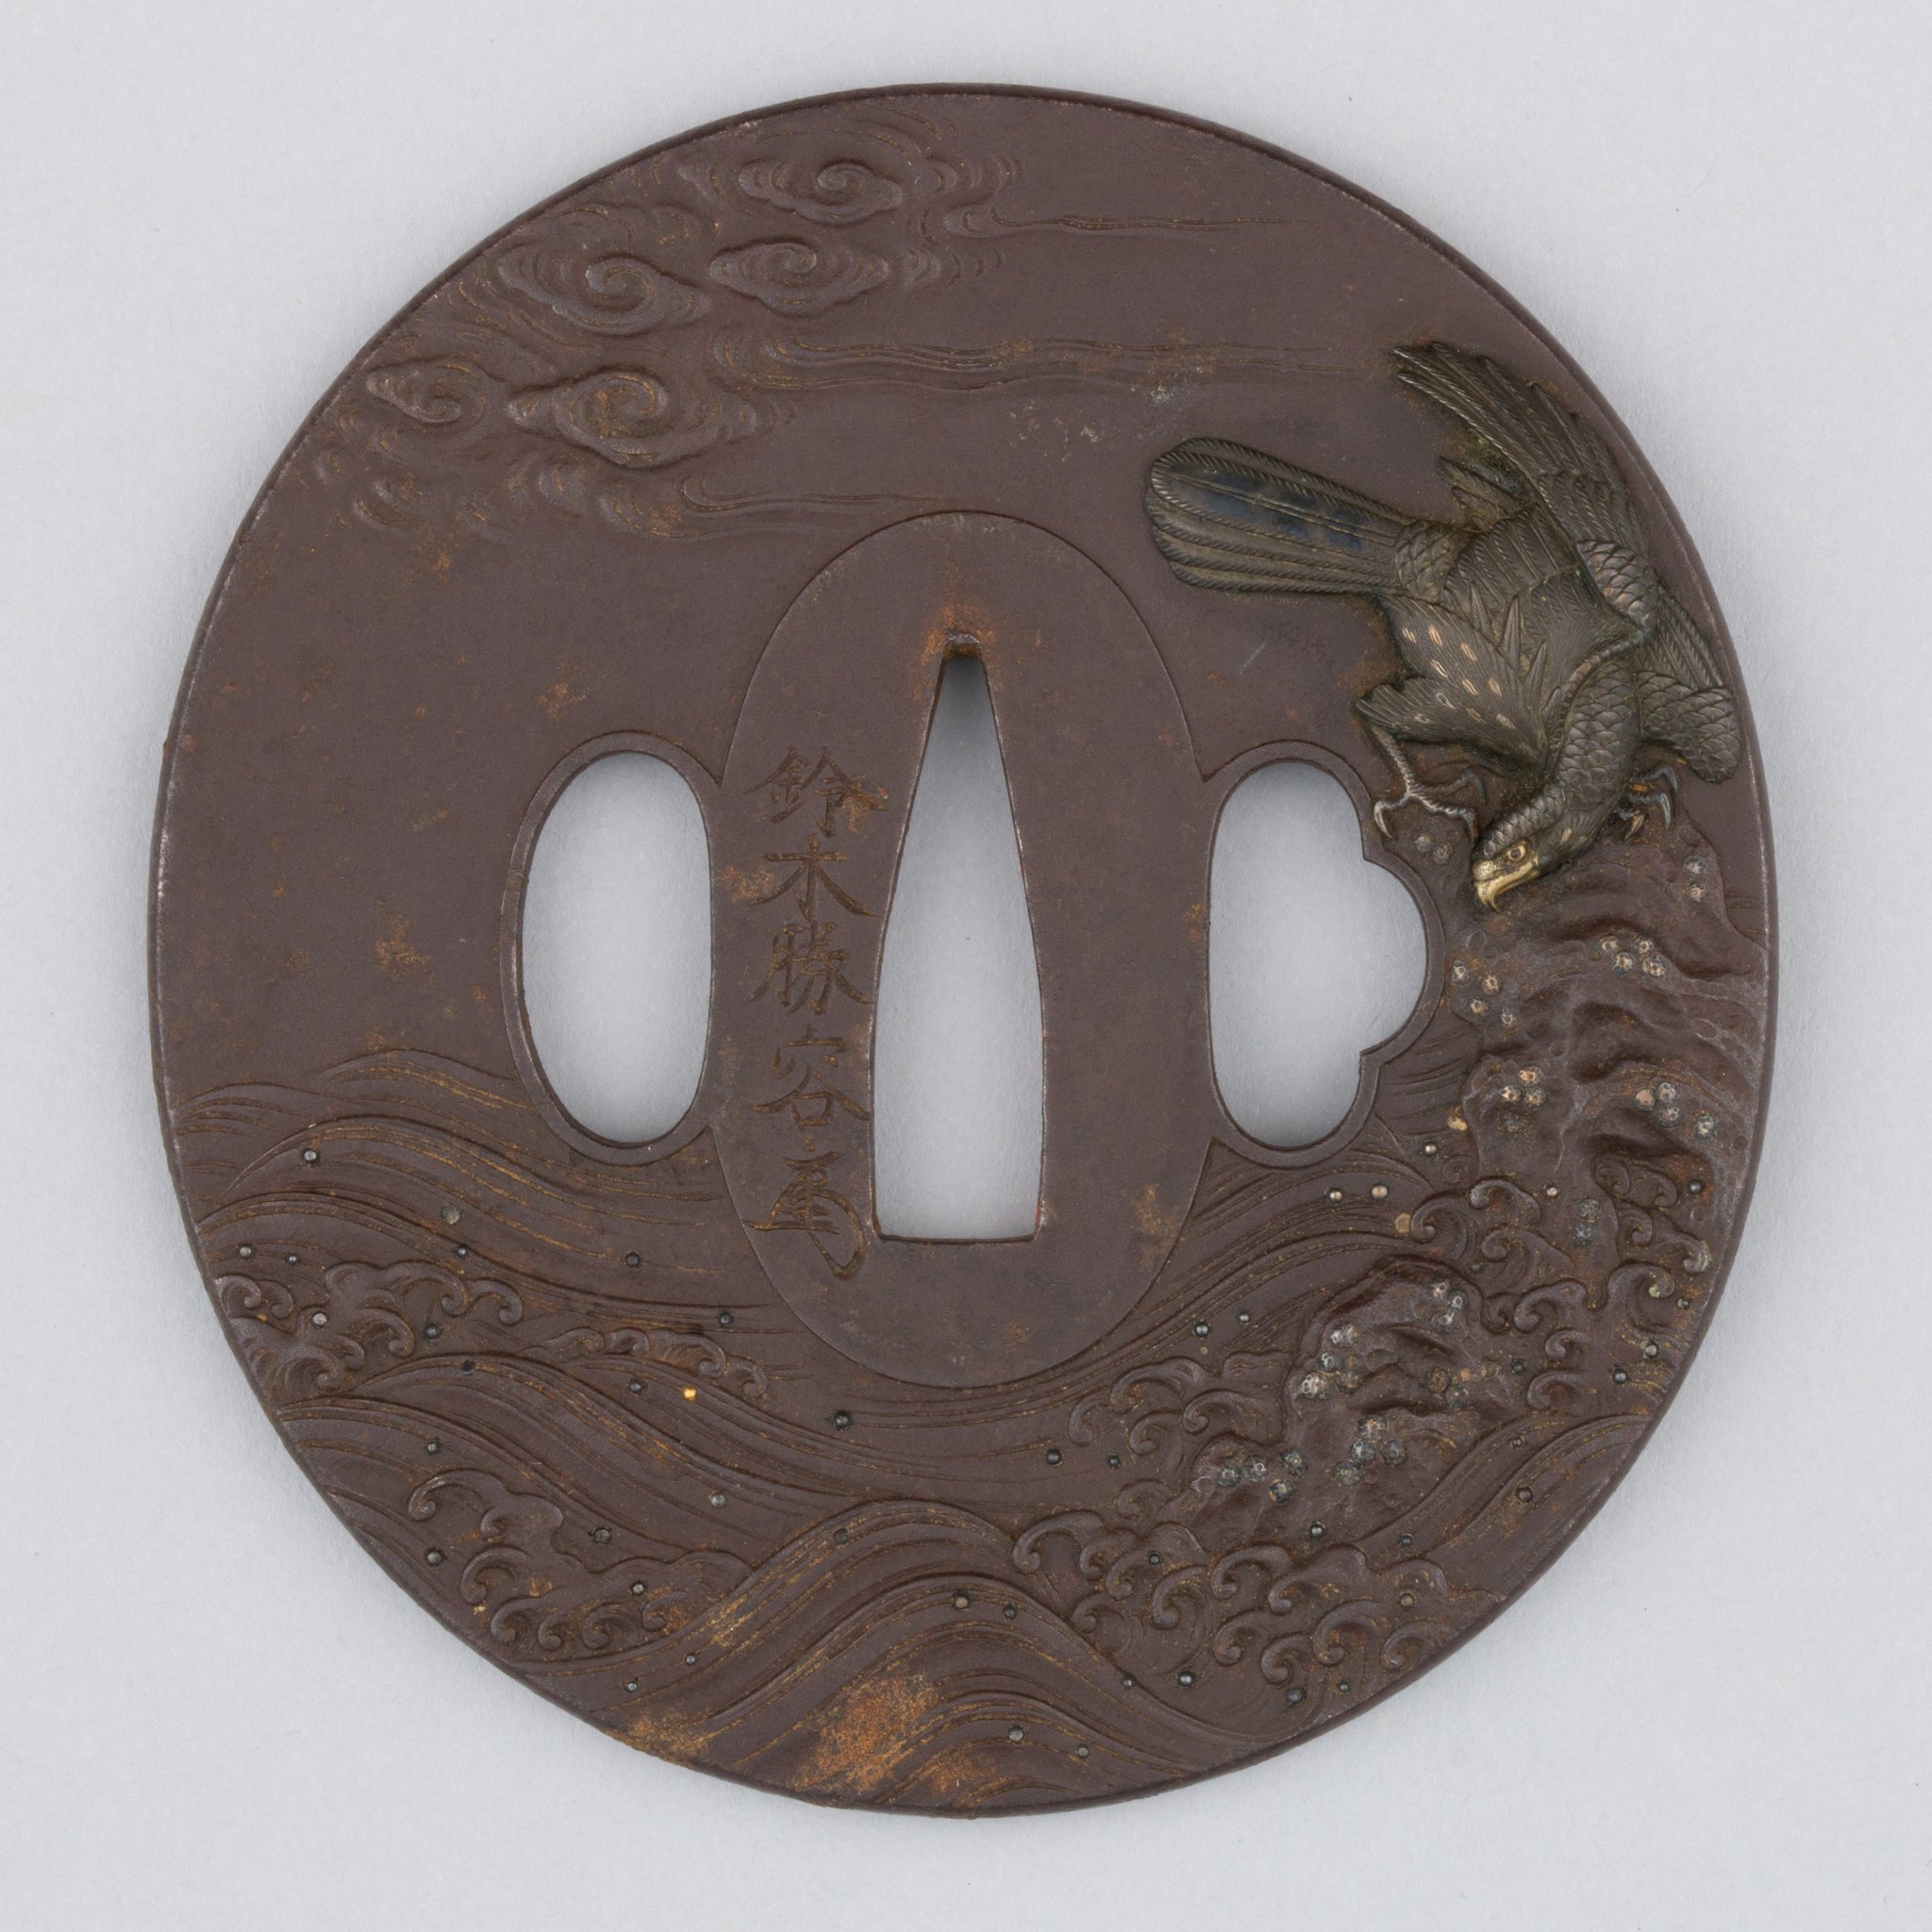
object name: sword guard tsuba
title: Sword Guard (Tsuba)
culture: japanese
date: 1615-1868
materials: copper, gold, iron, silver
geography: japan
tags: birds